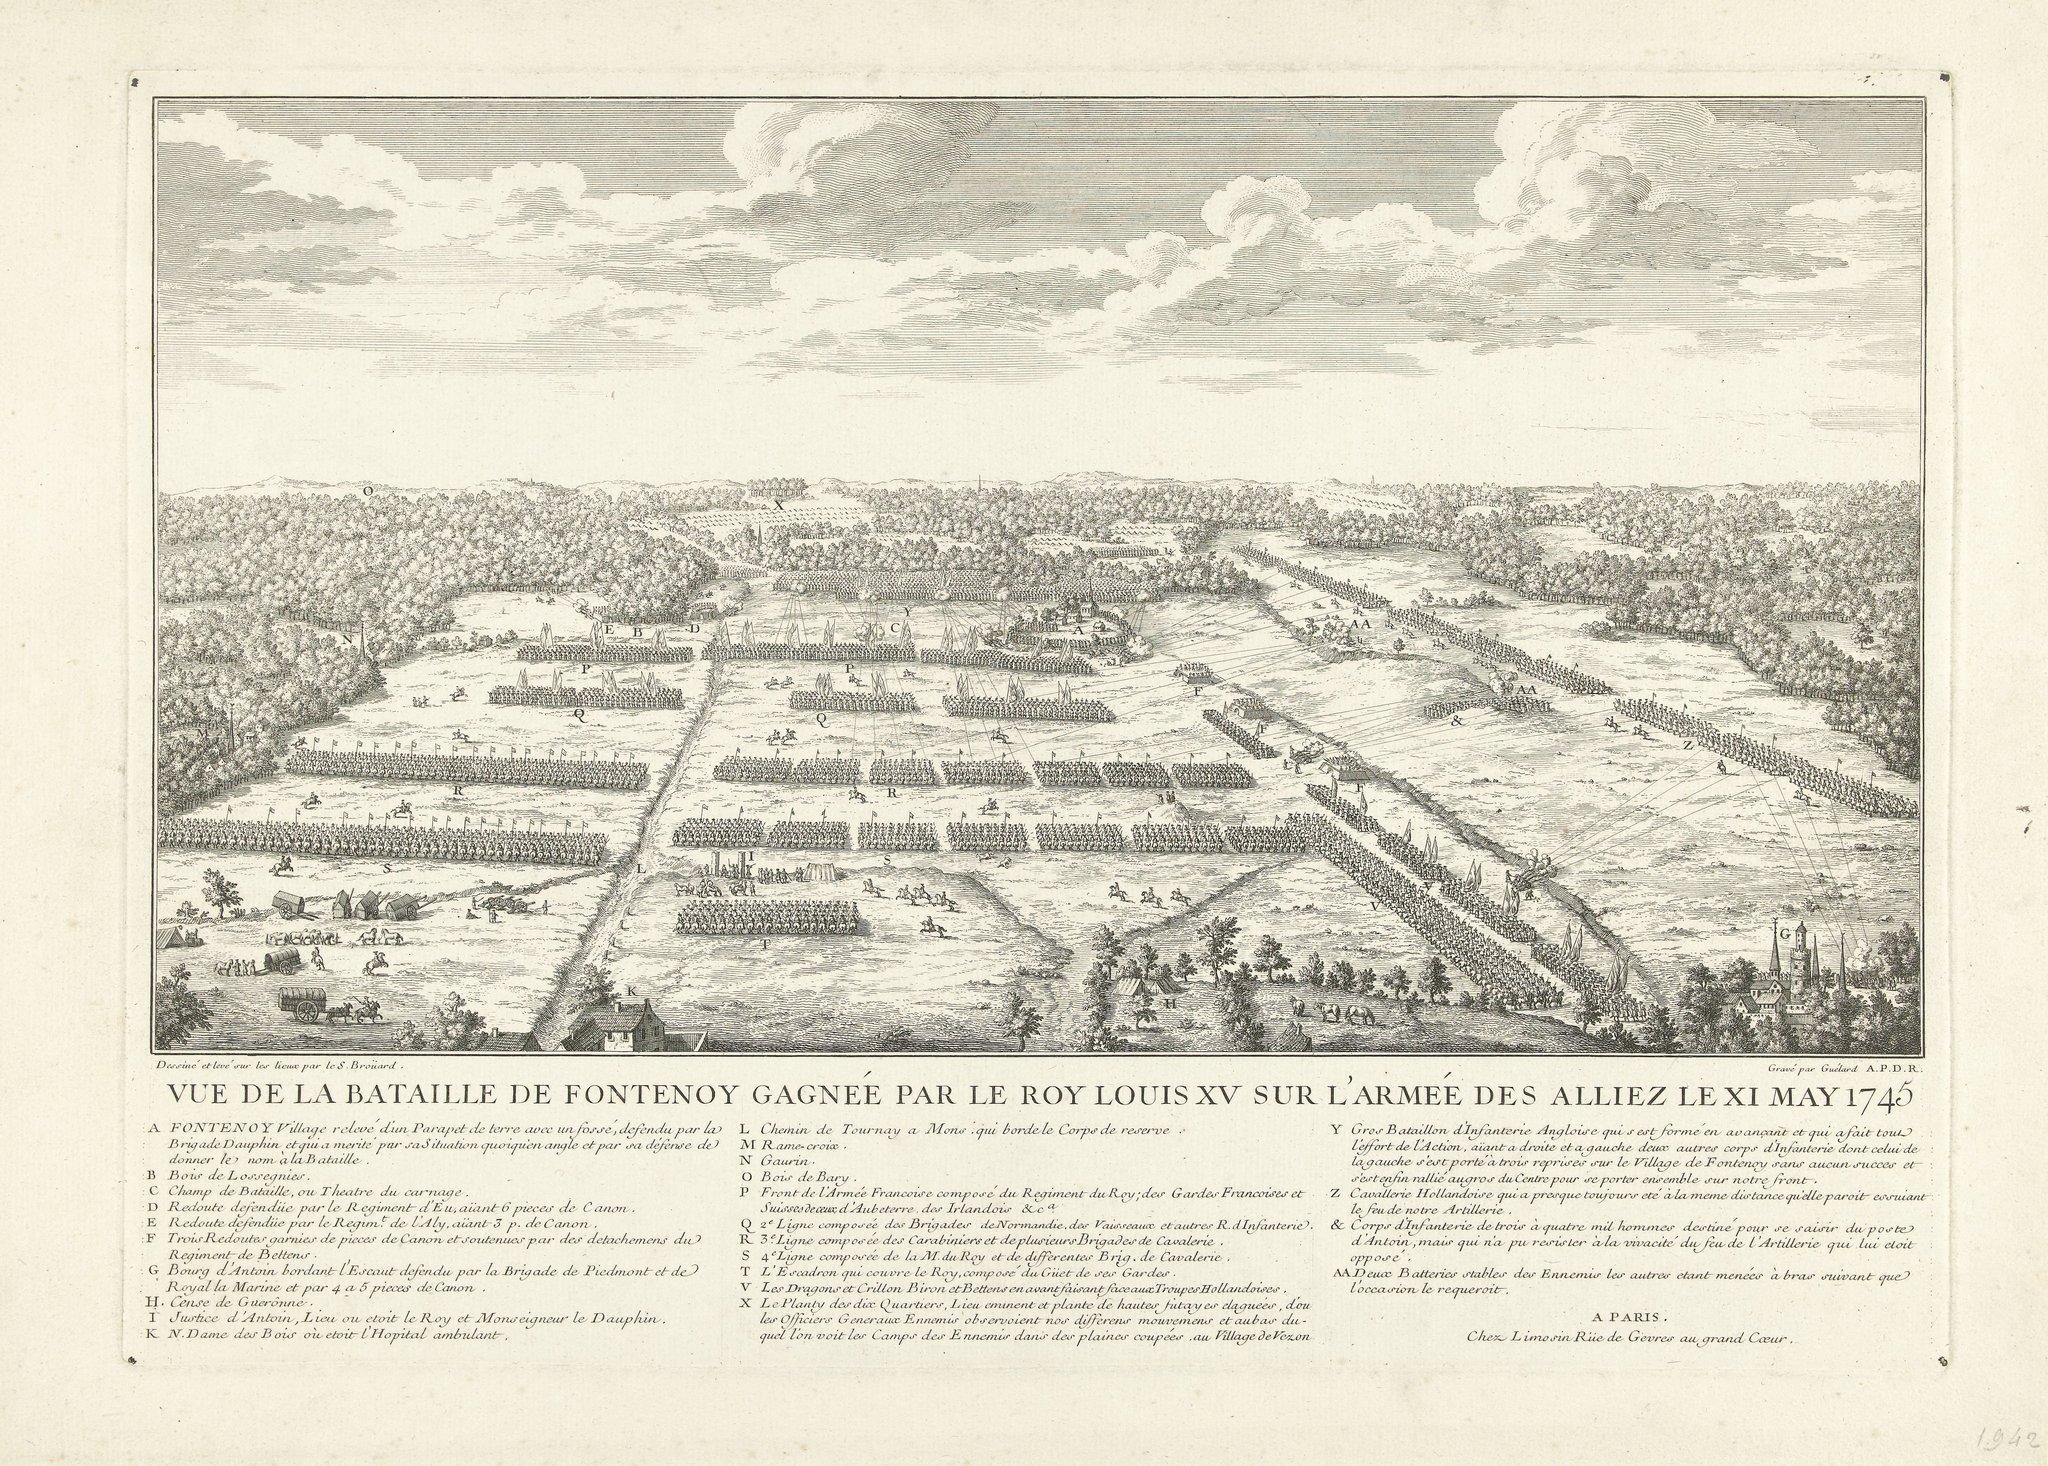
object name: print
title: Gezicht op de slag bij Fontenoy, 1745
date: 1745-1748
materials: paper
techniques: etching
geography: france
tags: battle (+ land forces)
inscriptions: collector's mark: Lugt 2228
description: Gezicht op de slag bij Fontenoy op 11 mei 1745 tussen het Geallieerde leger en de Fransen. In het onderschrift de legenda A-AA in het Frans.